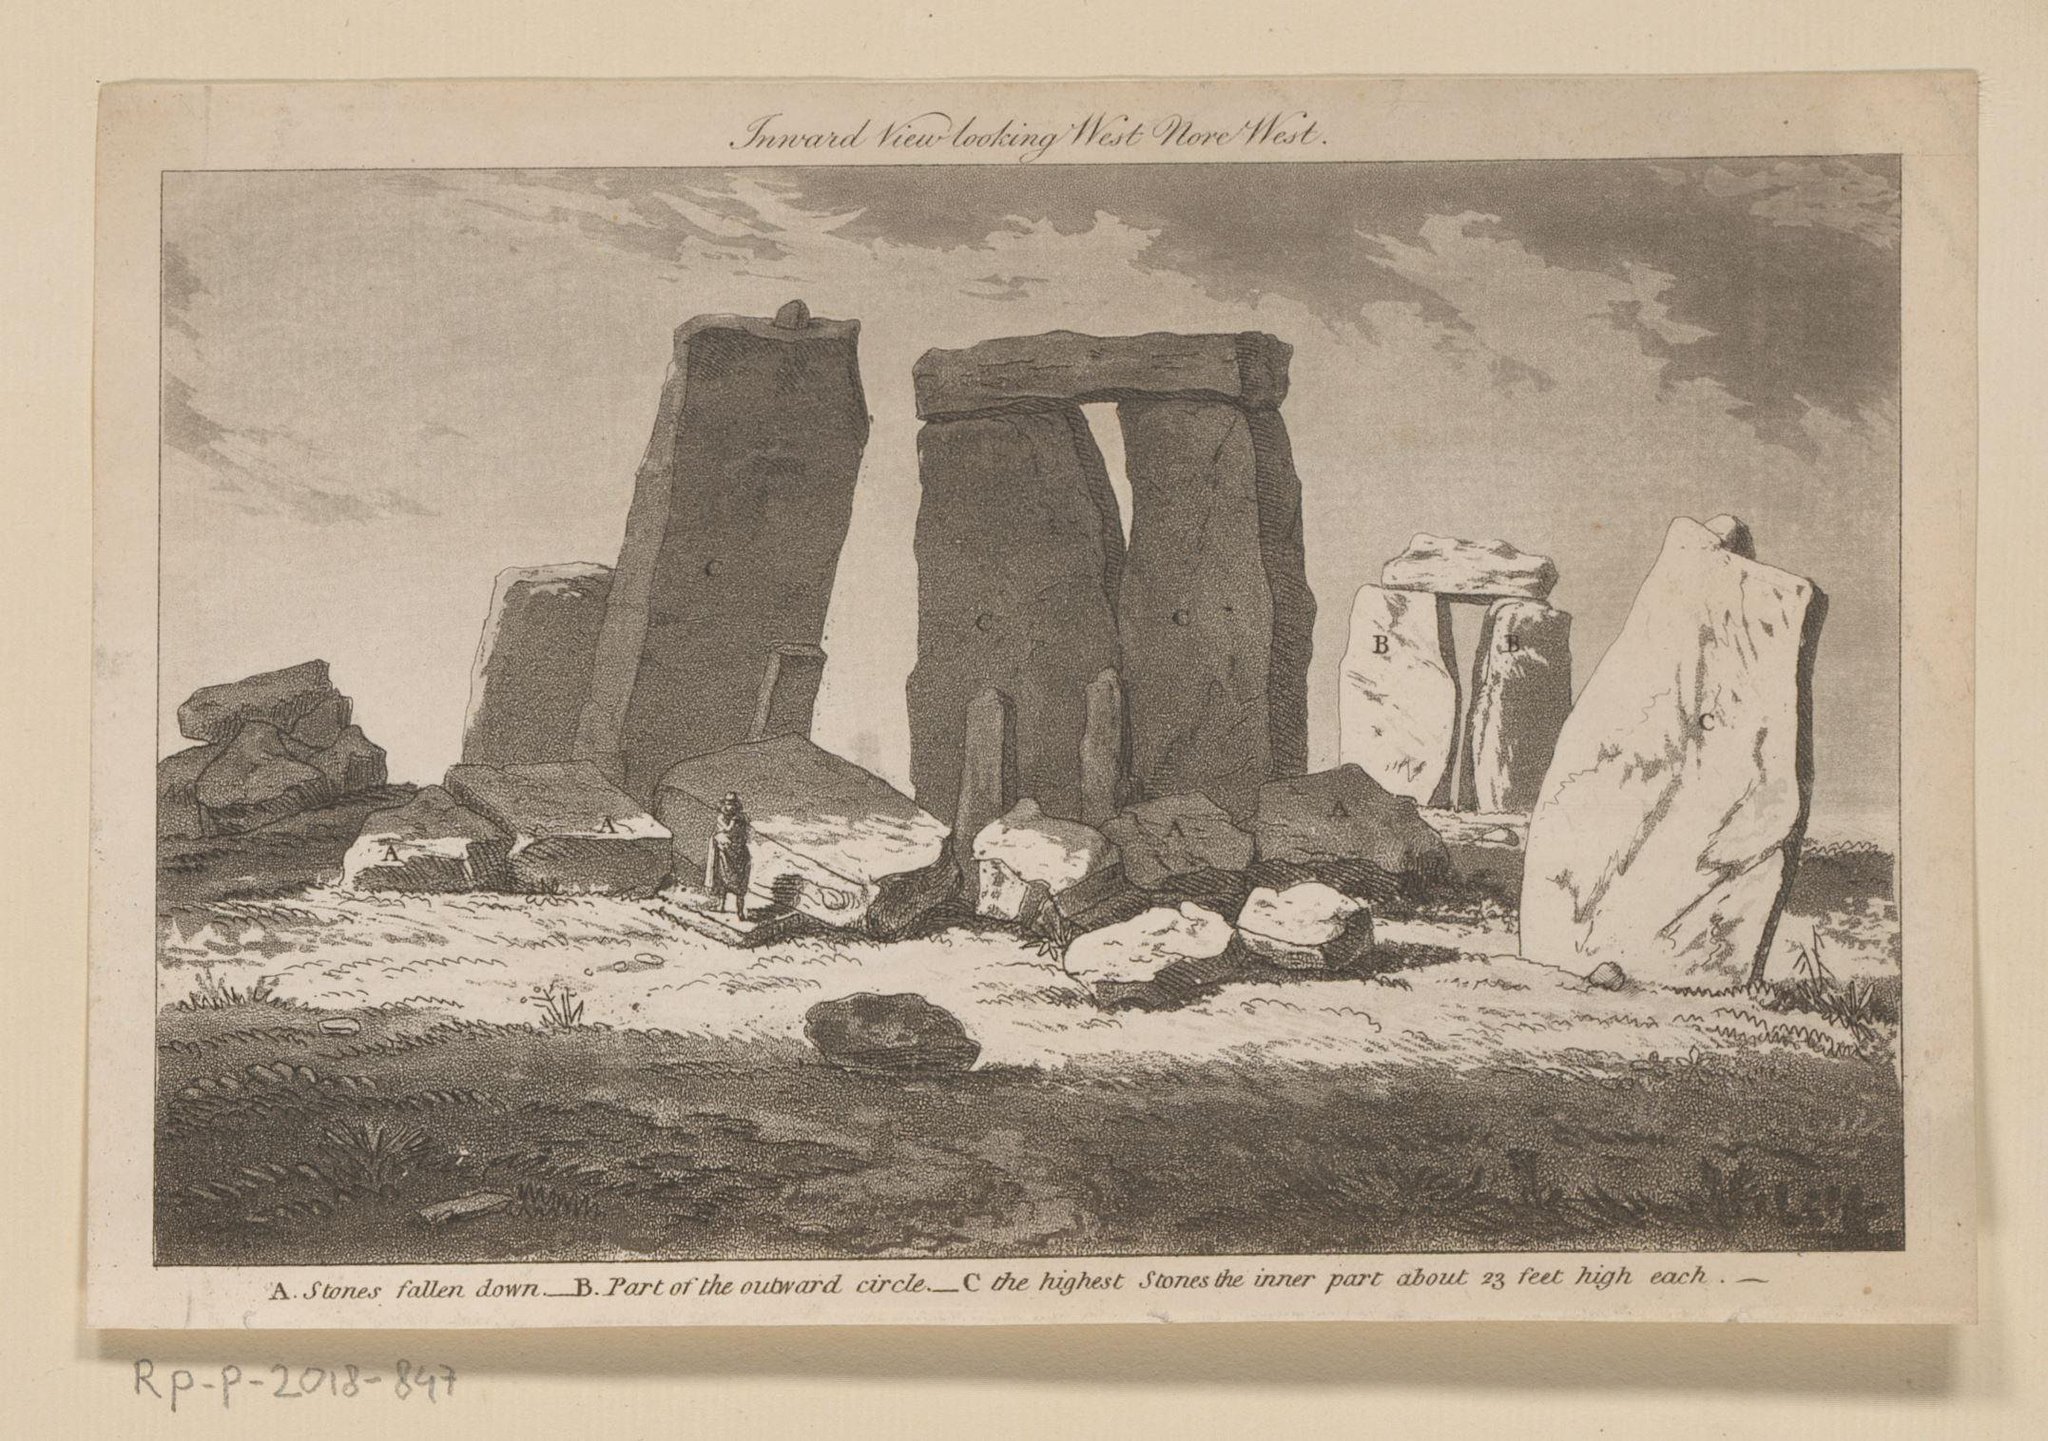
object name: print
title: Gezicht van binnen de Stonehenge naar het noordwesten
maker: Anonymous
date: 1800-1900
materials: paper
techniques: aquatint, etching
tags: stonehenge